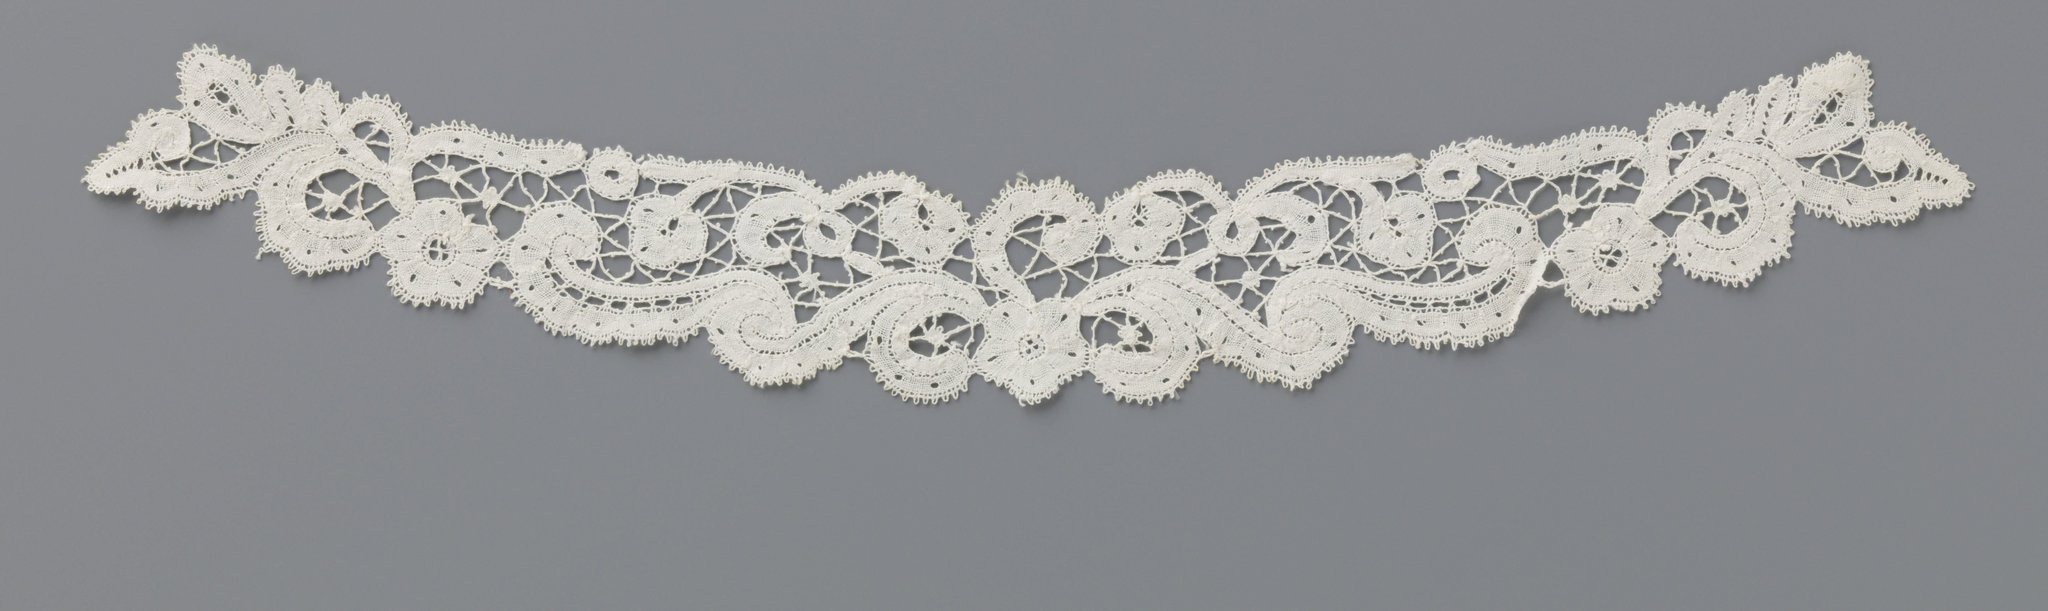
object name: guimpe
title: Guimpe van kloskant met symmetrisch voluten patroon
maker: leon sacré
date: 1907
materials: linen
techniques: lace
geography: brussels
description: Guimpe van naturelkleurige kloskant: Vlaamse guipure. Symmetrische patroon van s-voluten en c-voluten waartussen in totaal drie rondvormige bloemen of vruchten en drie rozetbloemen. Vlechtengrond. Afwerking aan alle zijden met ongelijke schulpen, die voortkomen uit het patroon. De guimpe is flauw gebogen rechthoekig.